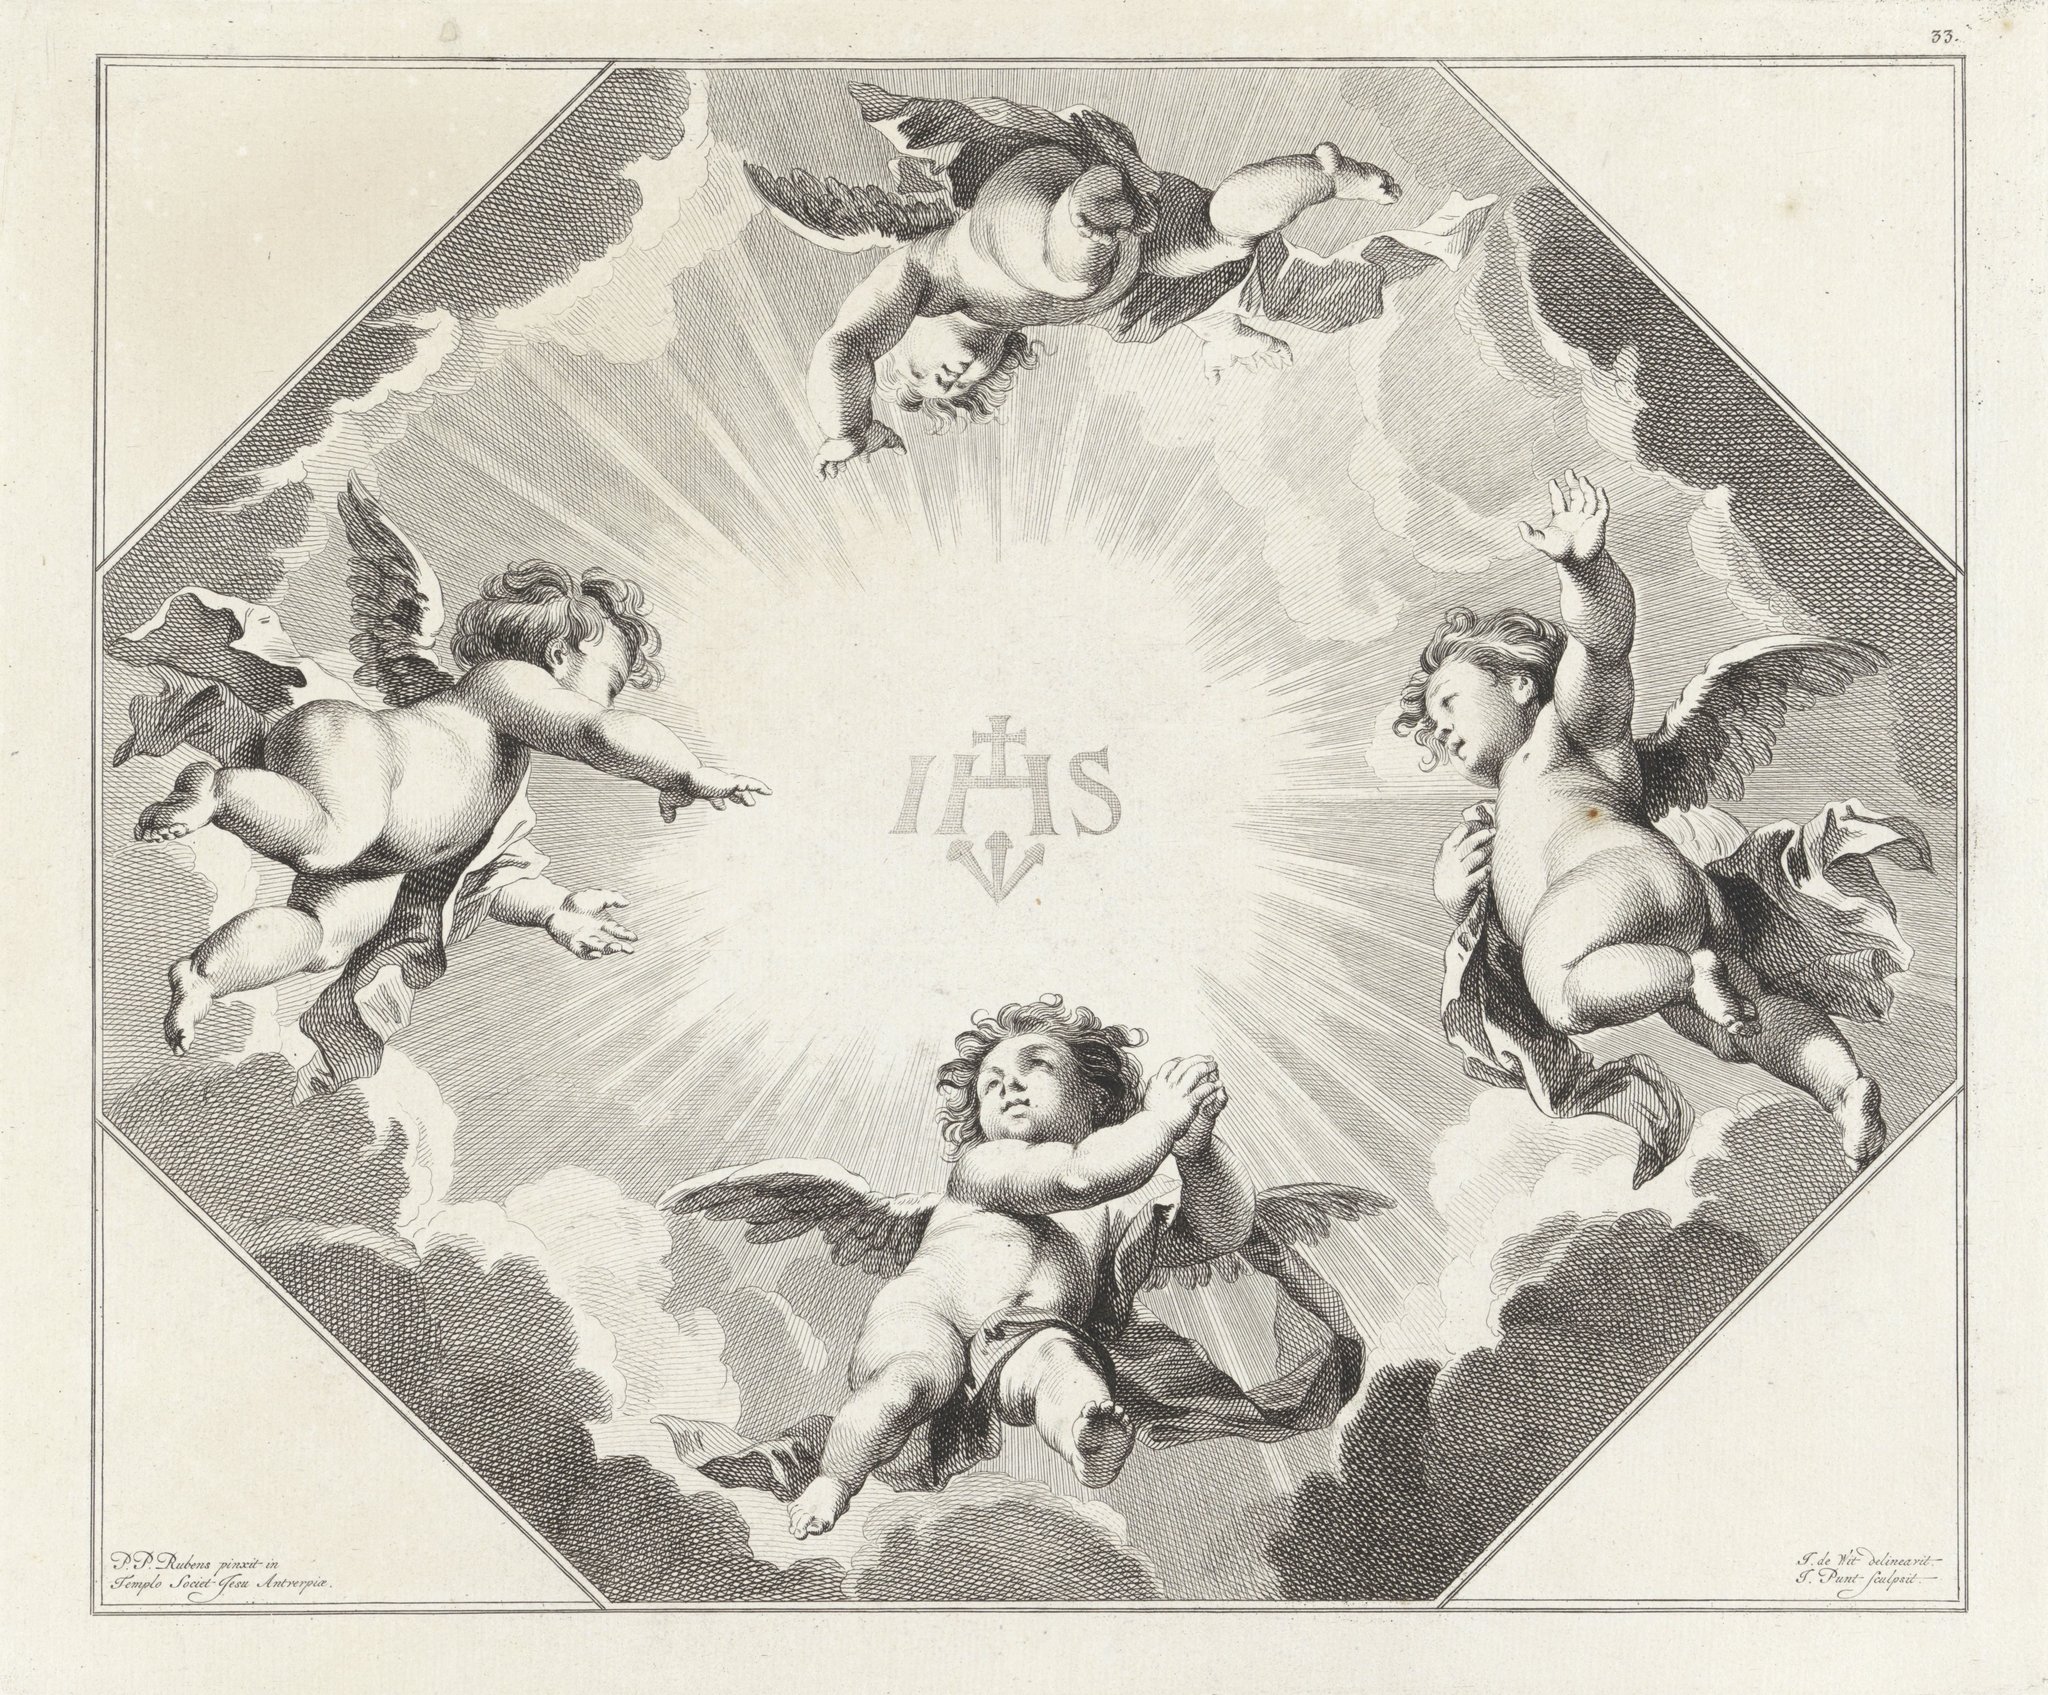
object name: print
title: Les plat-fonds ou les tableaux des galeries / De plafonds of gallerystukken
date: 1751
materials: paper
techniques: engraving, etching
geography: amsterdam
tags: ihs ('iesus hominum salvator') ~ symbol of christ (+ angel(s))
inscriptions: collector's mark: Lugt 240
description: Vier engelen vliegen rond het monogram van Christus dat is omgeven door lichtstralen. Eén van hen vouwt de handen in aanbidding.